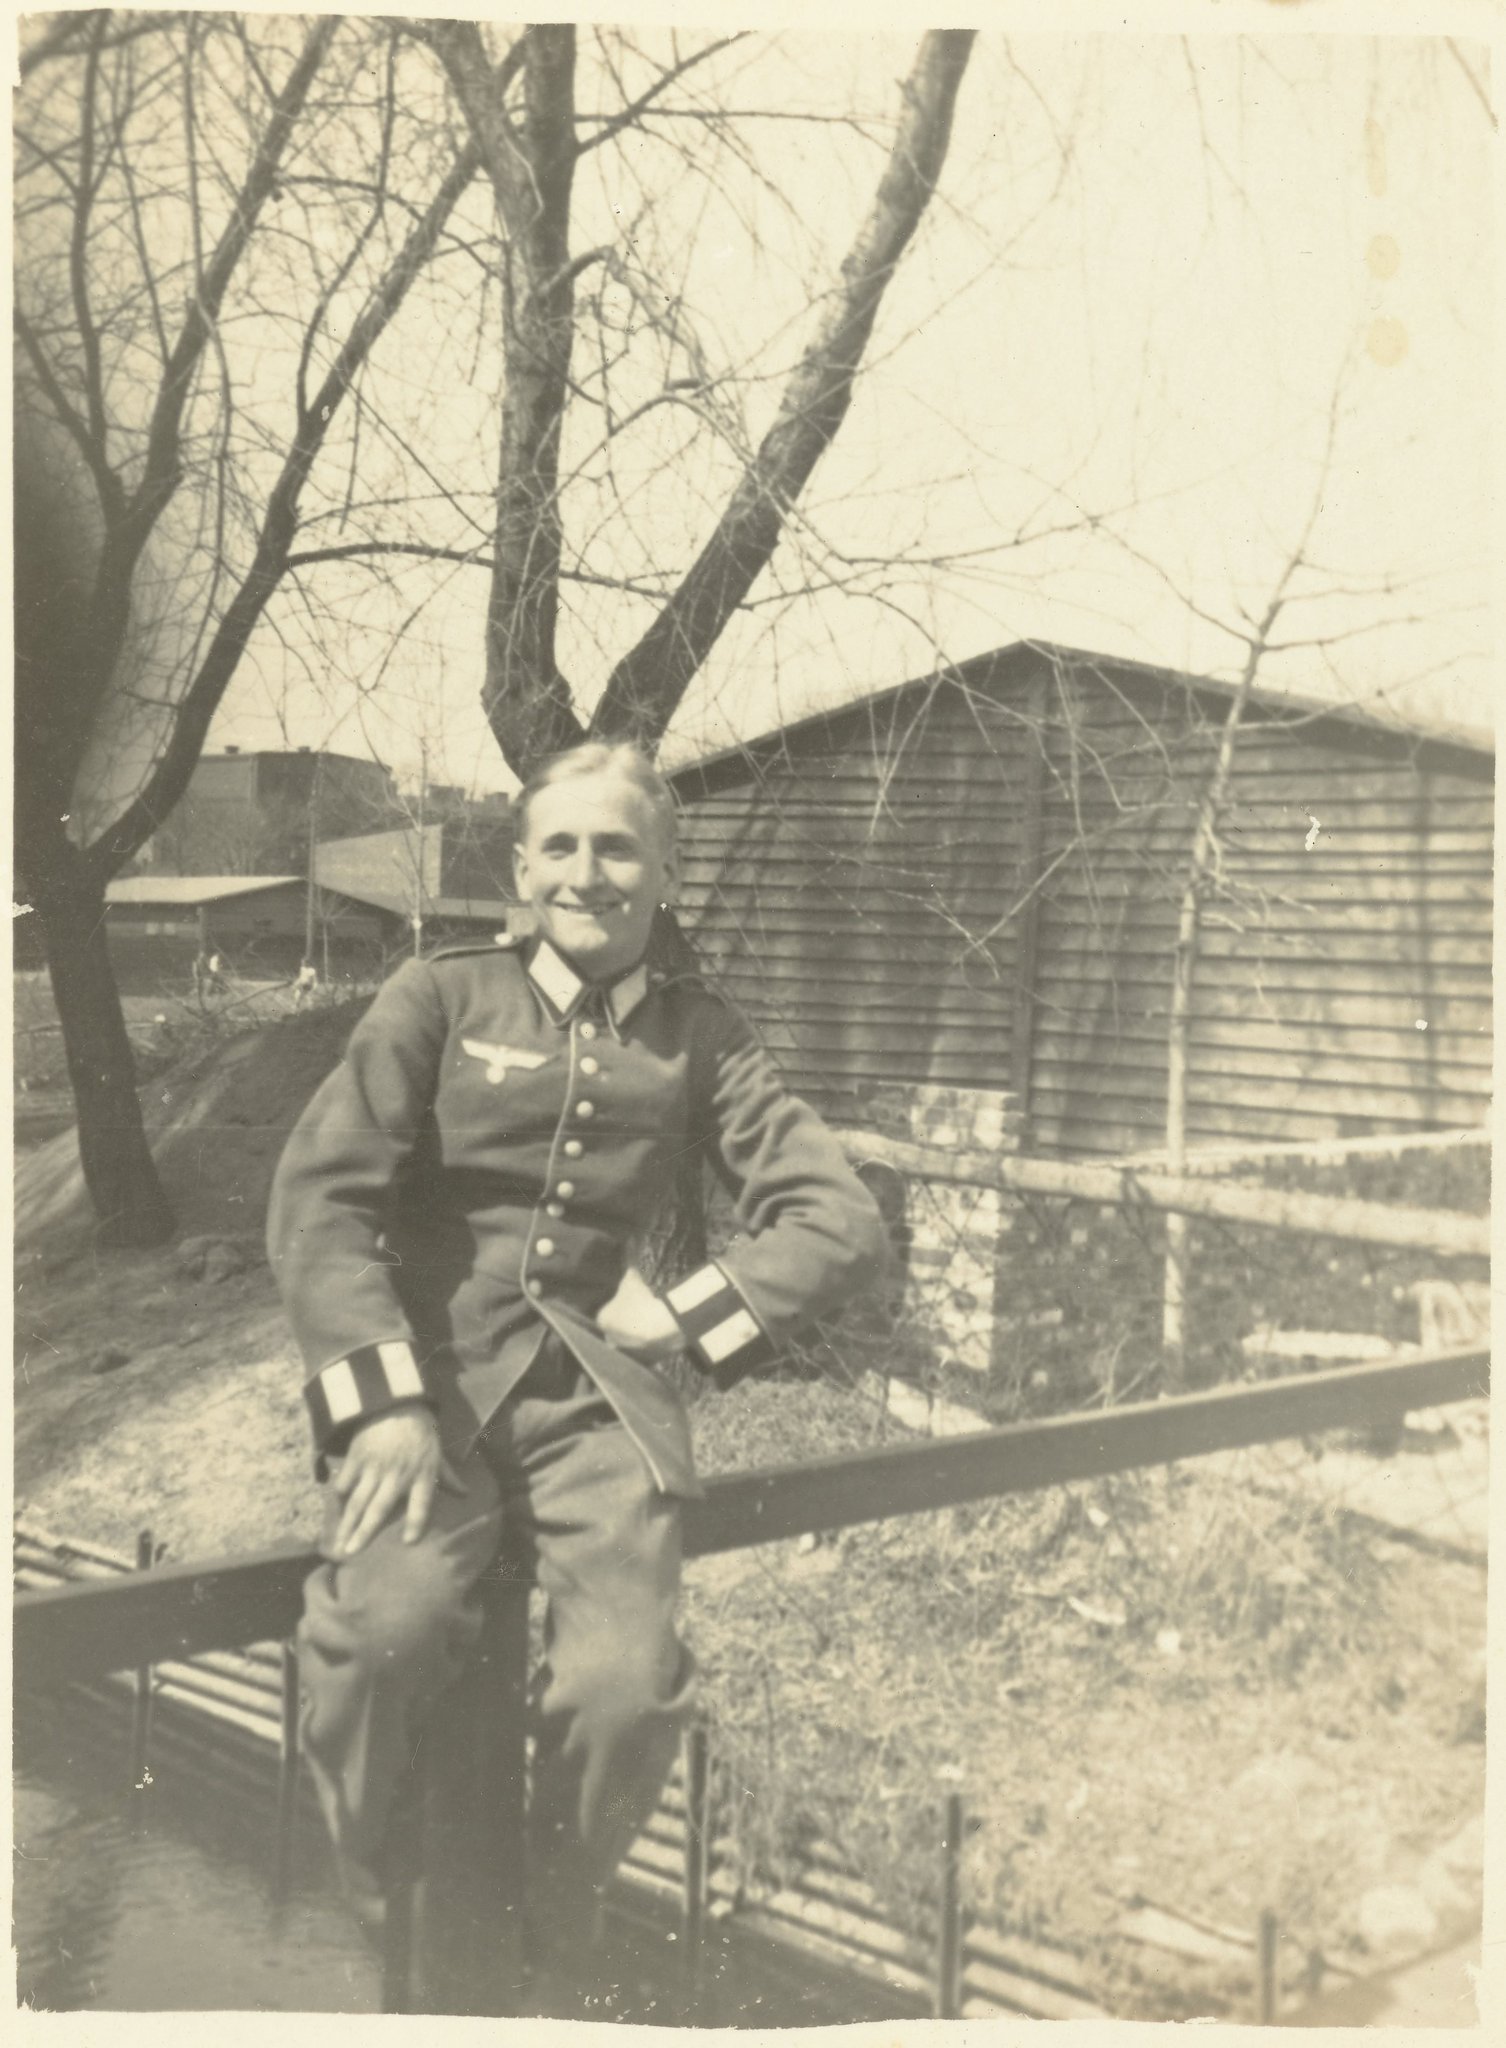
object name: photograph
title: Een Wehrmacht soldaat op een hek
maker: Anonymous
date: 1940-1945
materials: photographic support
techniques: gelatin silver print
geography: belgium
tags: netherlands, germany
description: Een Wehrmacht soldaat zit op een hek. Hij heeft zwart/ witte manchetten. Foto behorend bij album 'Kriegserinnerungen'.